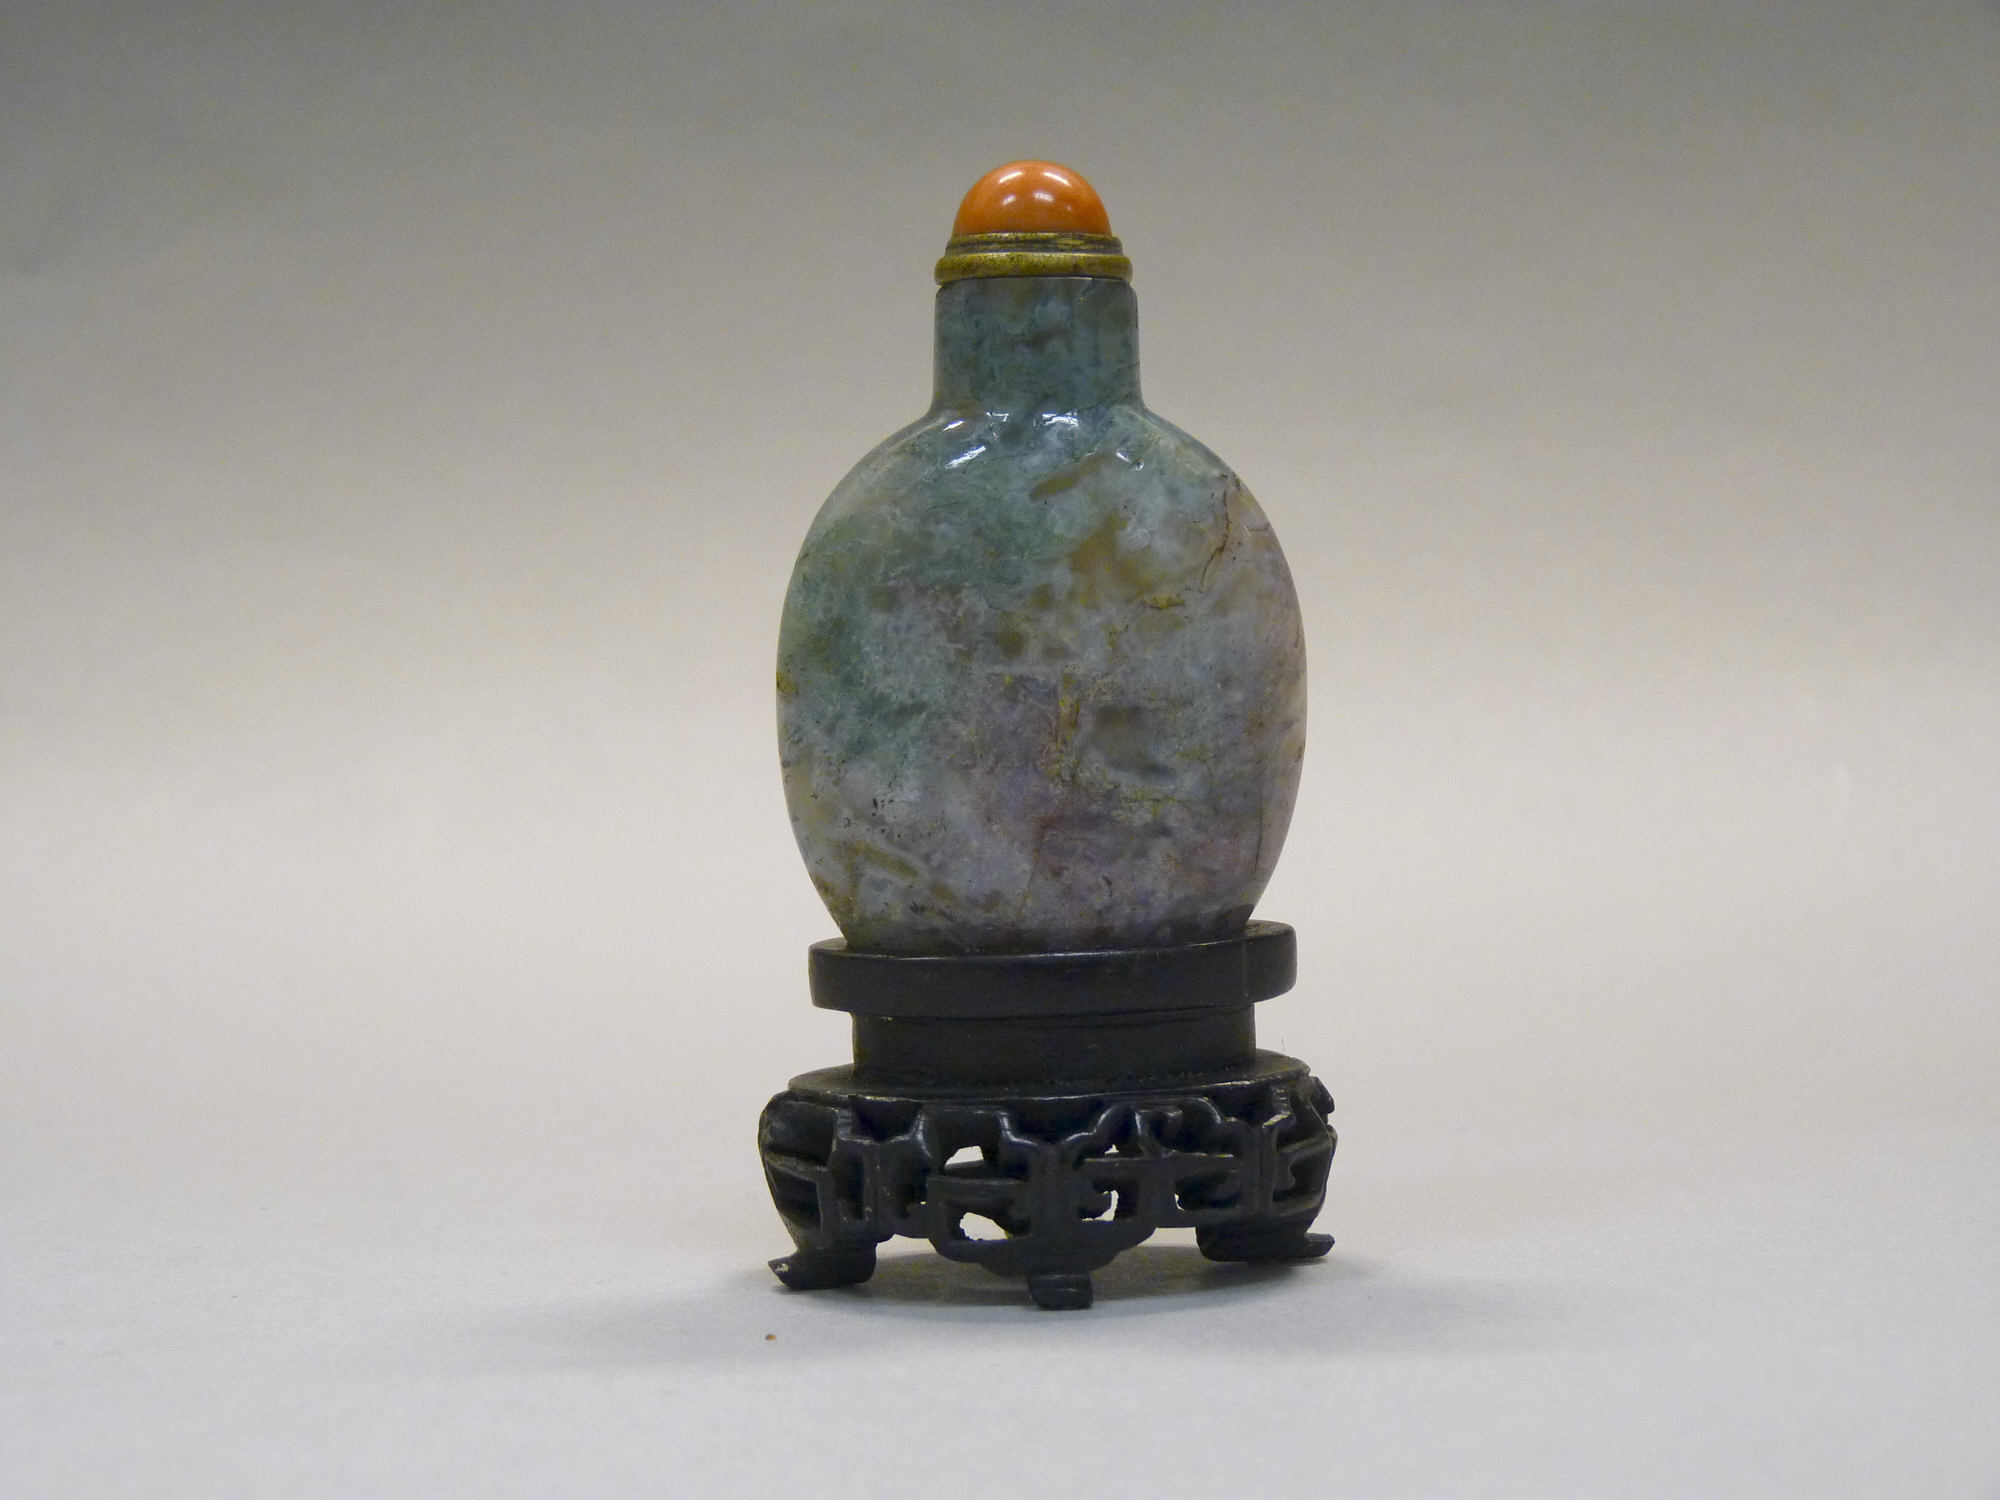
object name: snuff bottle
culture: chinese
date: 1736-1795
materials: stone, coral